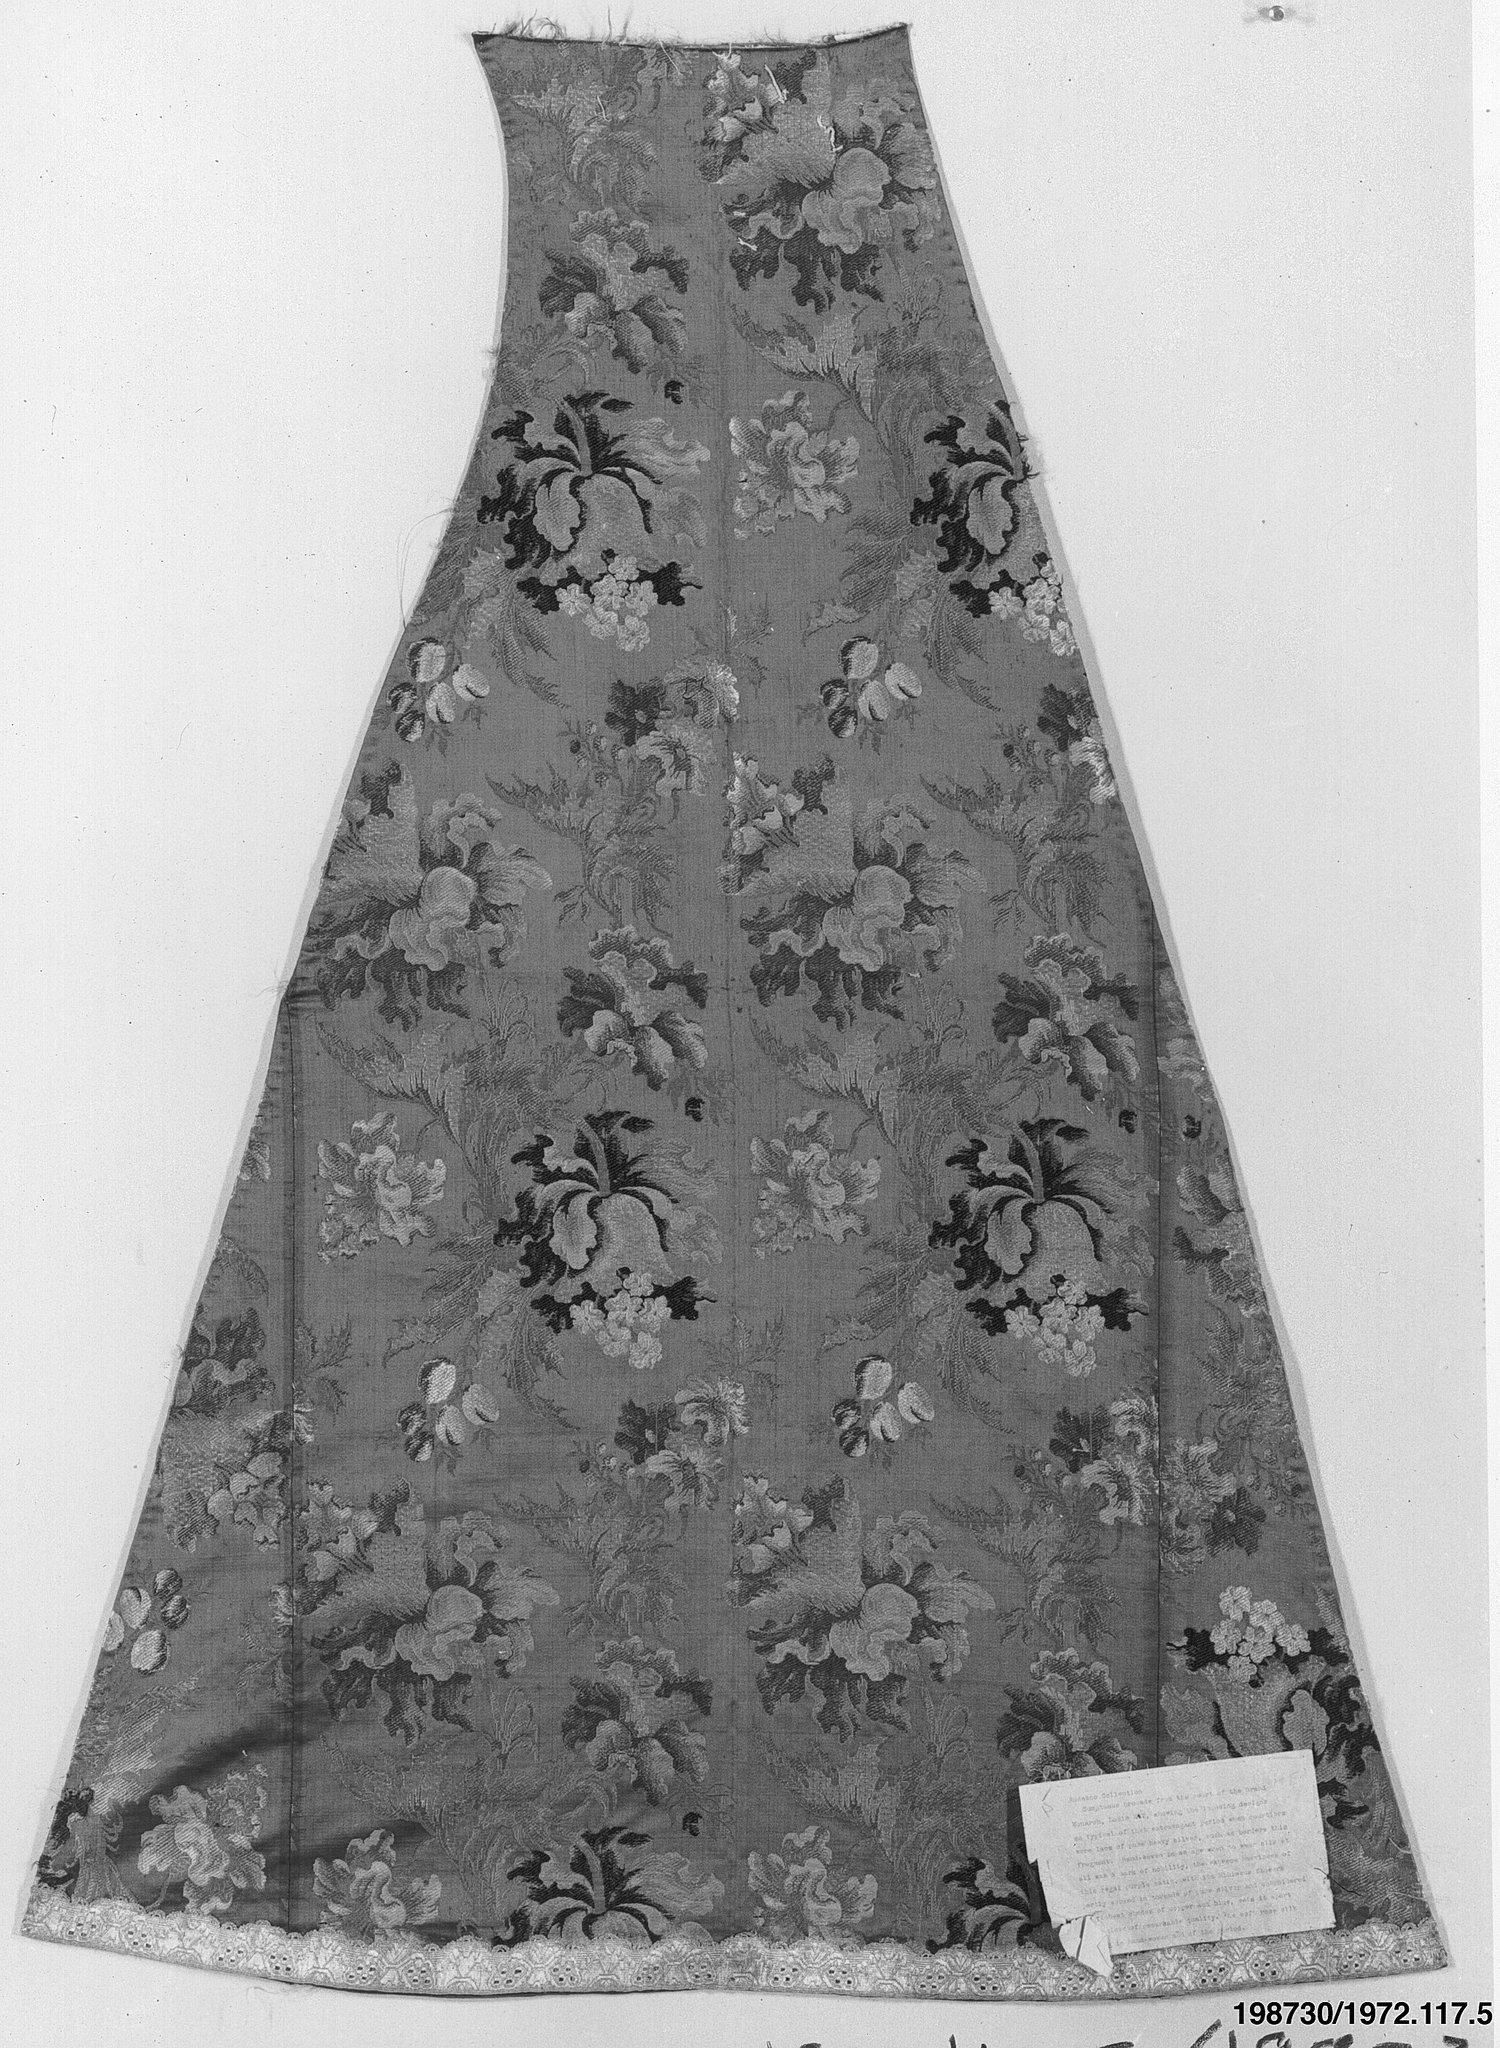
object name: piece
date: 1730-1739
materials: metal thread, silk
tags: flowers,leaves